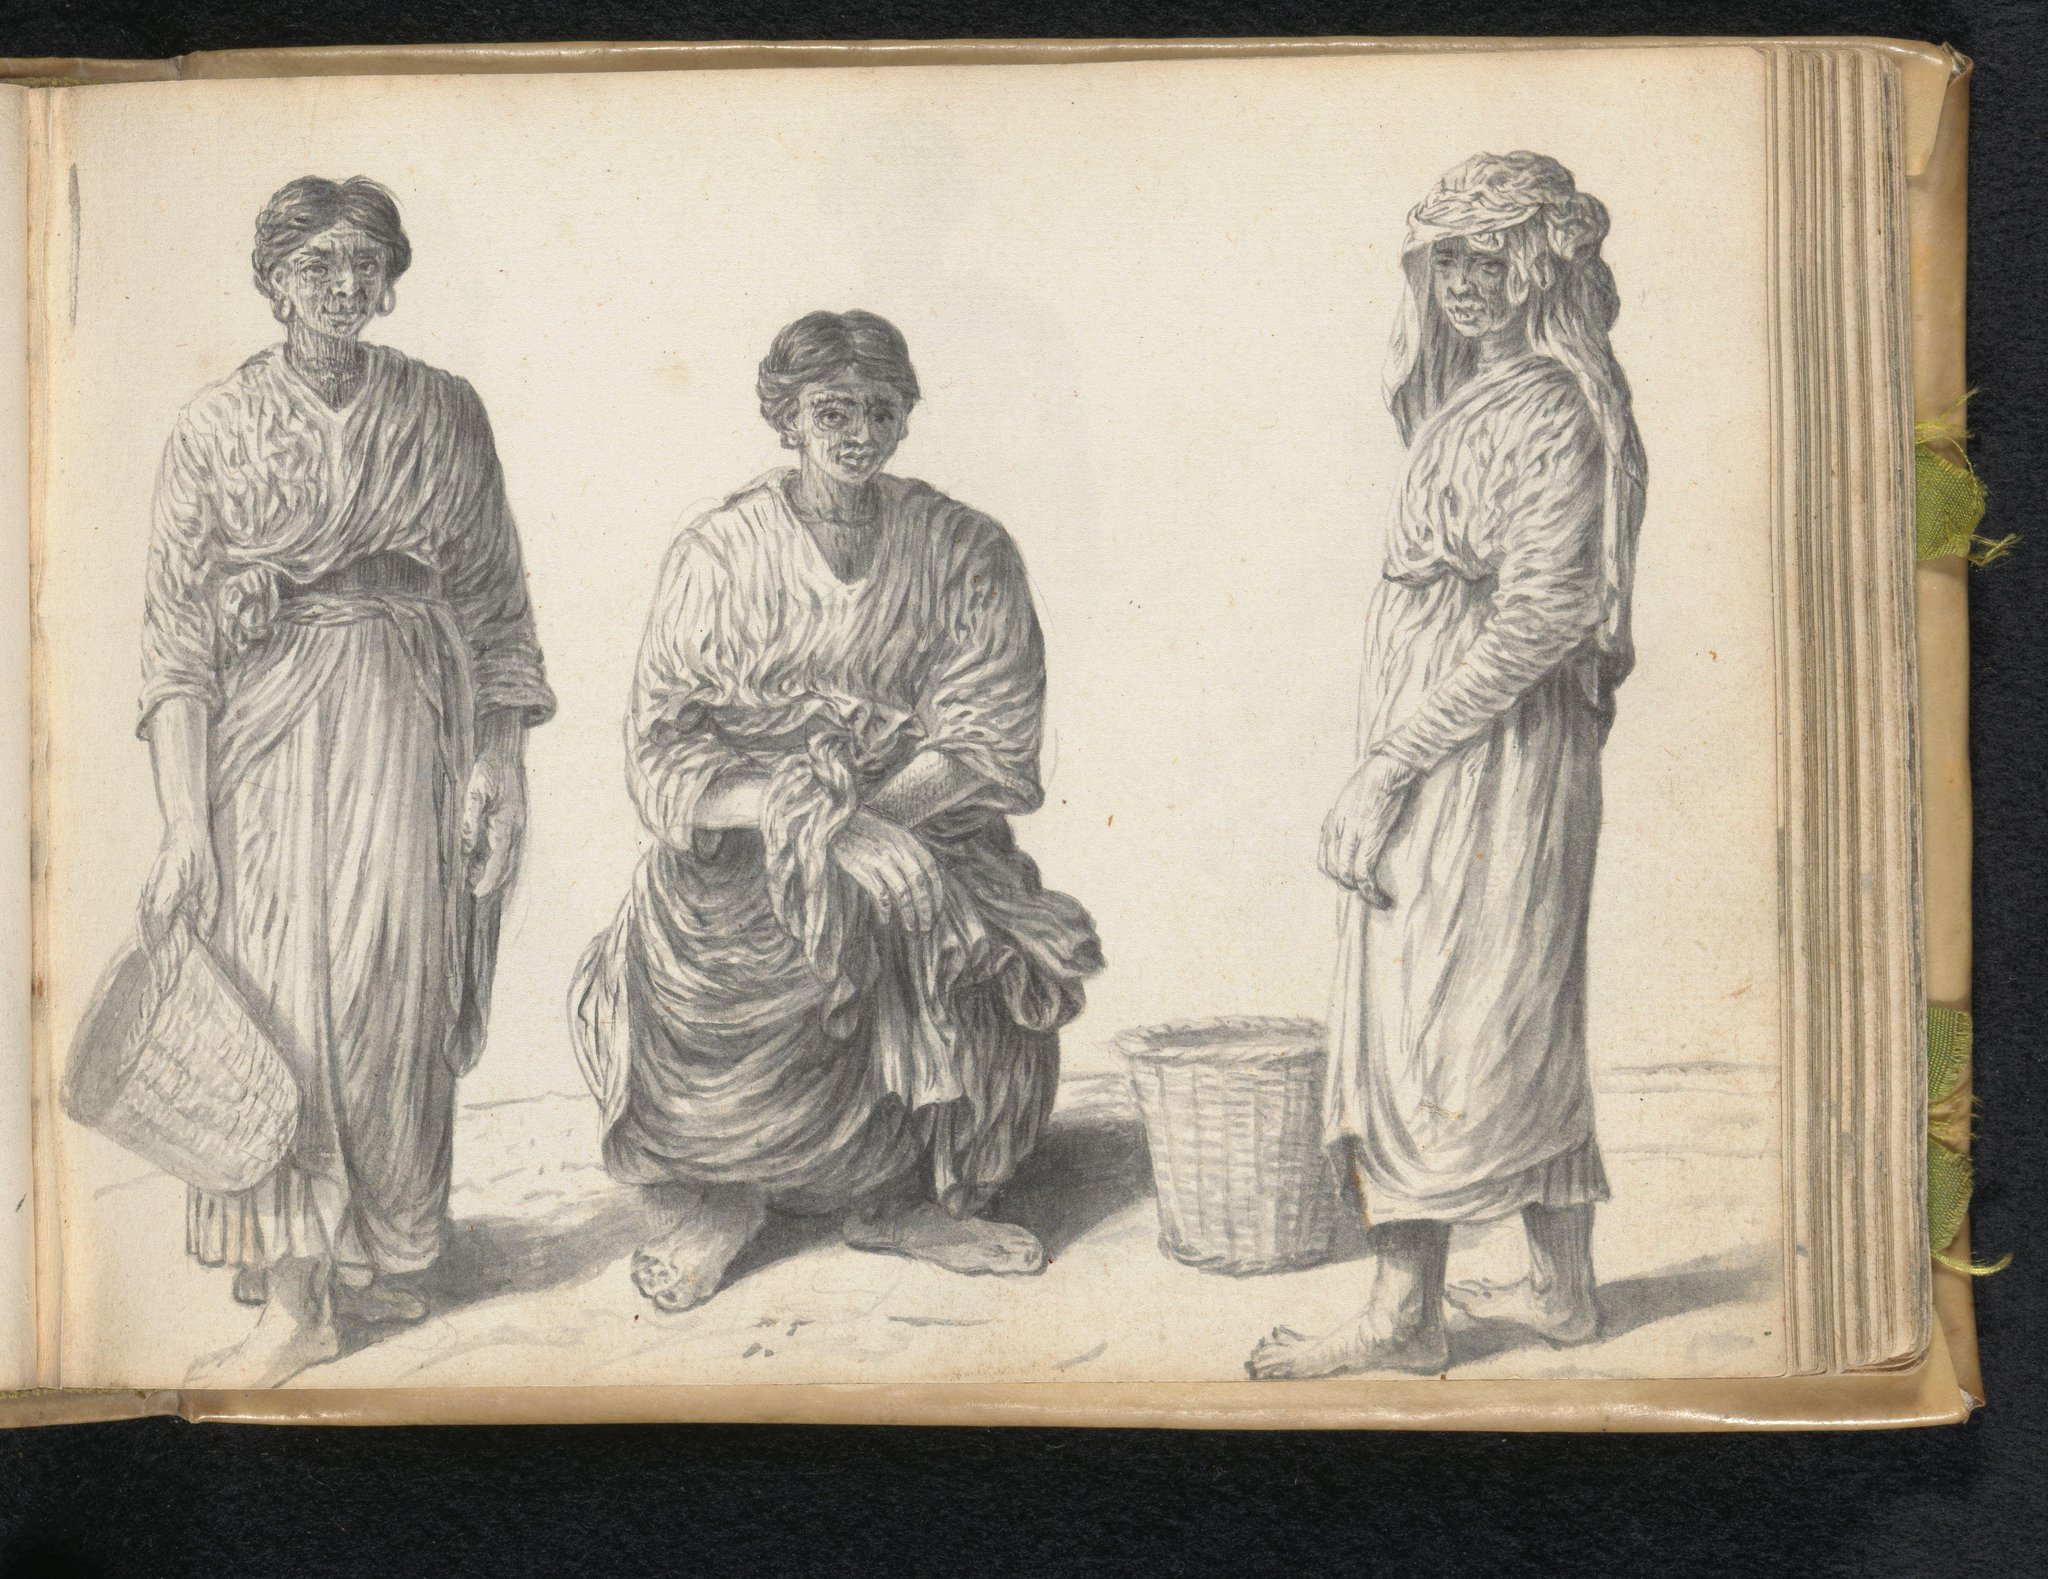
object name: sketchbook leaf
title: Three Sinhalese women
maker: esaias boursse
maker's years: 1631-1672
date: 1662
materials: ink, paper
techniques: brush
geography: sri lanka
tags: asiatic races and peoples (with name), skirt (with name), clothing for the upper part of the body (with name), styles of hairdress (with name) - ~women, sri lanka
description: Drie Singalese vrouwen, buiten langs de weg. Ze dragen elk een wikkelrok (redda), op Singalese manier geplooid en in de taille vastgestoken. Daarboven dragen ze een wijde Portugese bloes met V-hals en lange mouwen (hatte). Het haar van de links staande vrouw is in het midden gescheiden en naar achter getrokken in een wrong (condé). Haar doorboorde oorlellen zijn opgerekt. Ze draagt een lege mand in haar rechterhand. De middelste vrouw heeft dezelfde haardracht. Over haar op schoot liggende handen hangt een doek, mogelijkerwijs haar hoofddoek. De staande vrouw rechts staat bij een mand op de grond. Ze heeft om haar hoofd een doek gewikkeld die op haar rug tot aan haar middel reikt. Blad 35 uit een schetsboek met 117 bladen.